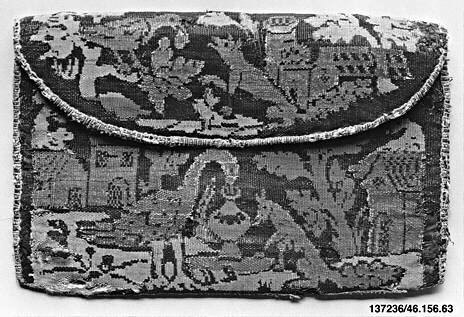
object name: letter case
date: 1667-1733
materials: metal thread, silk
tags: birds,houses,foxes